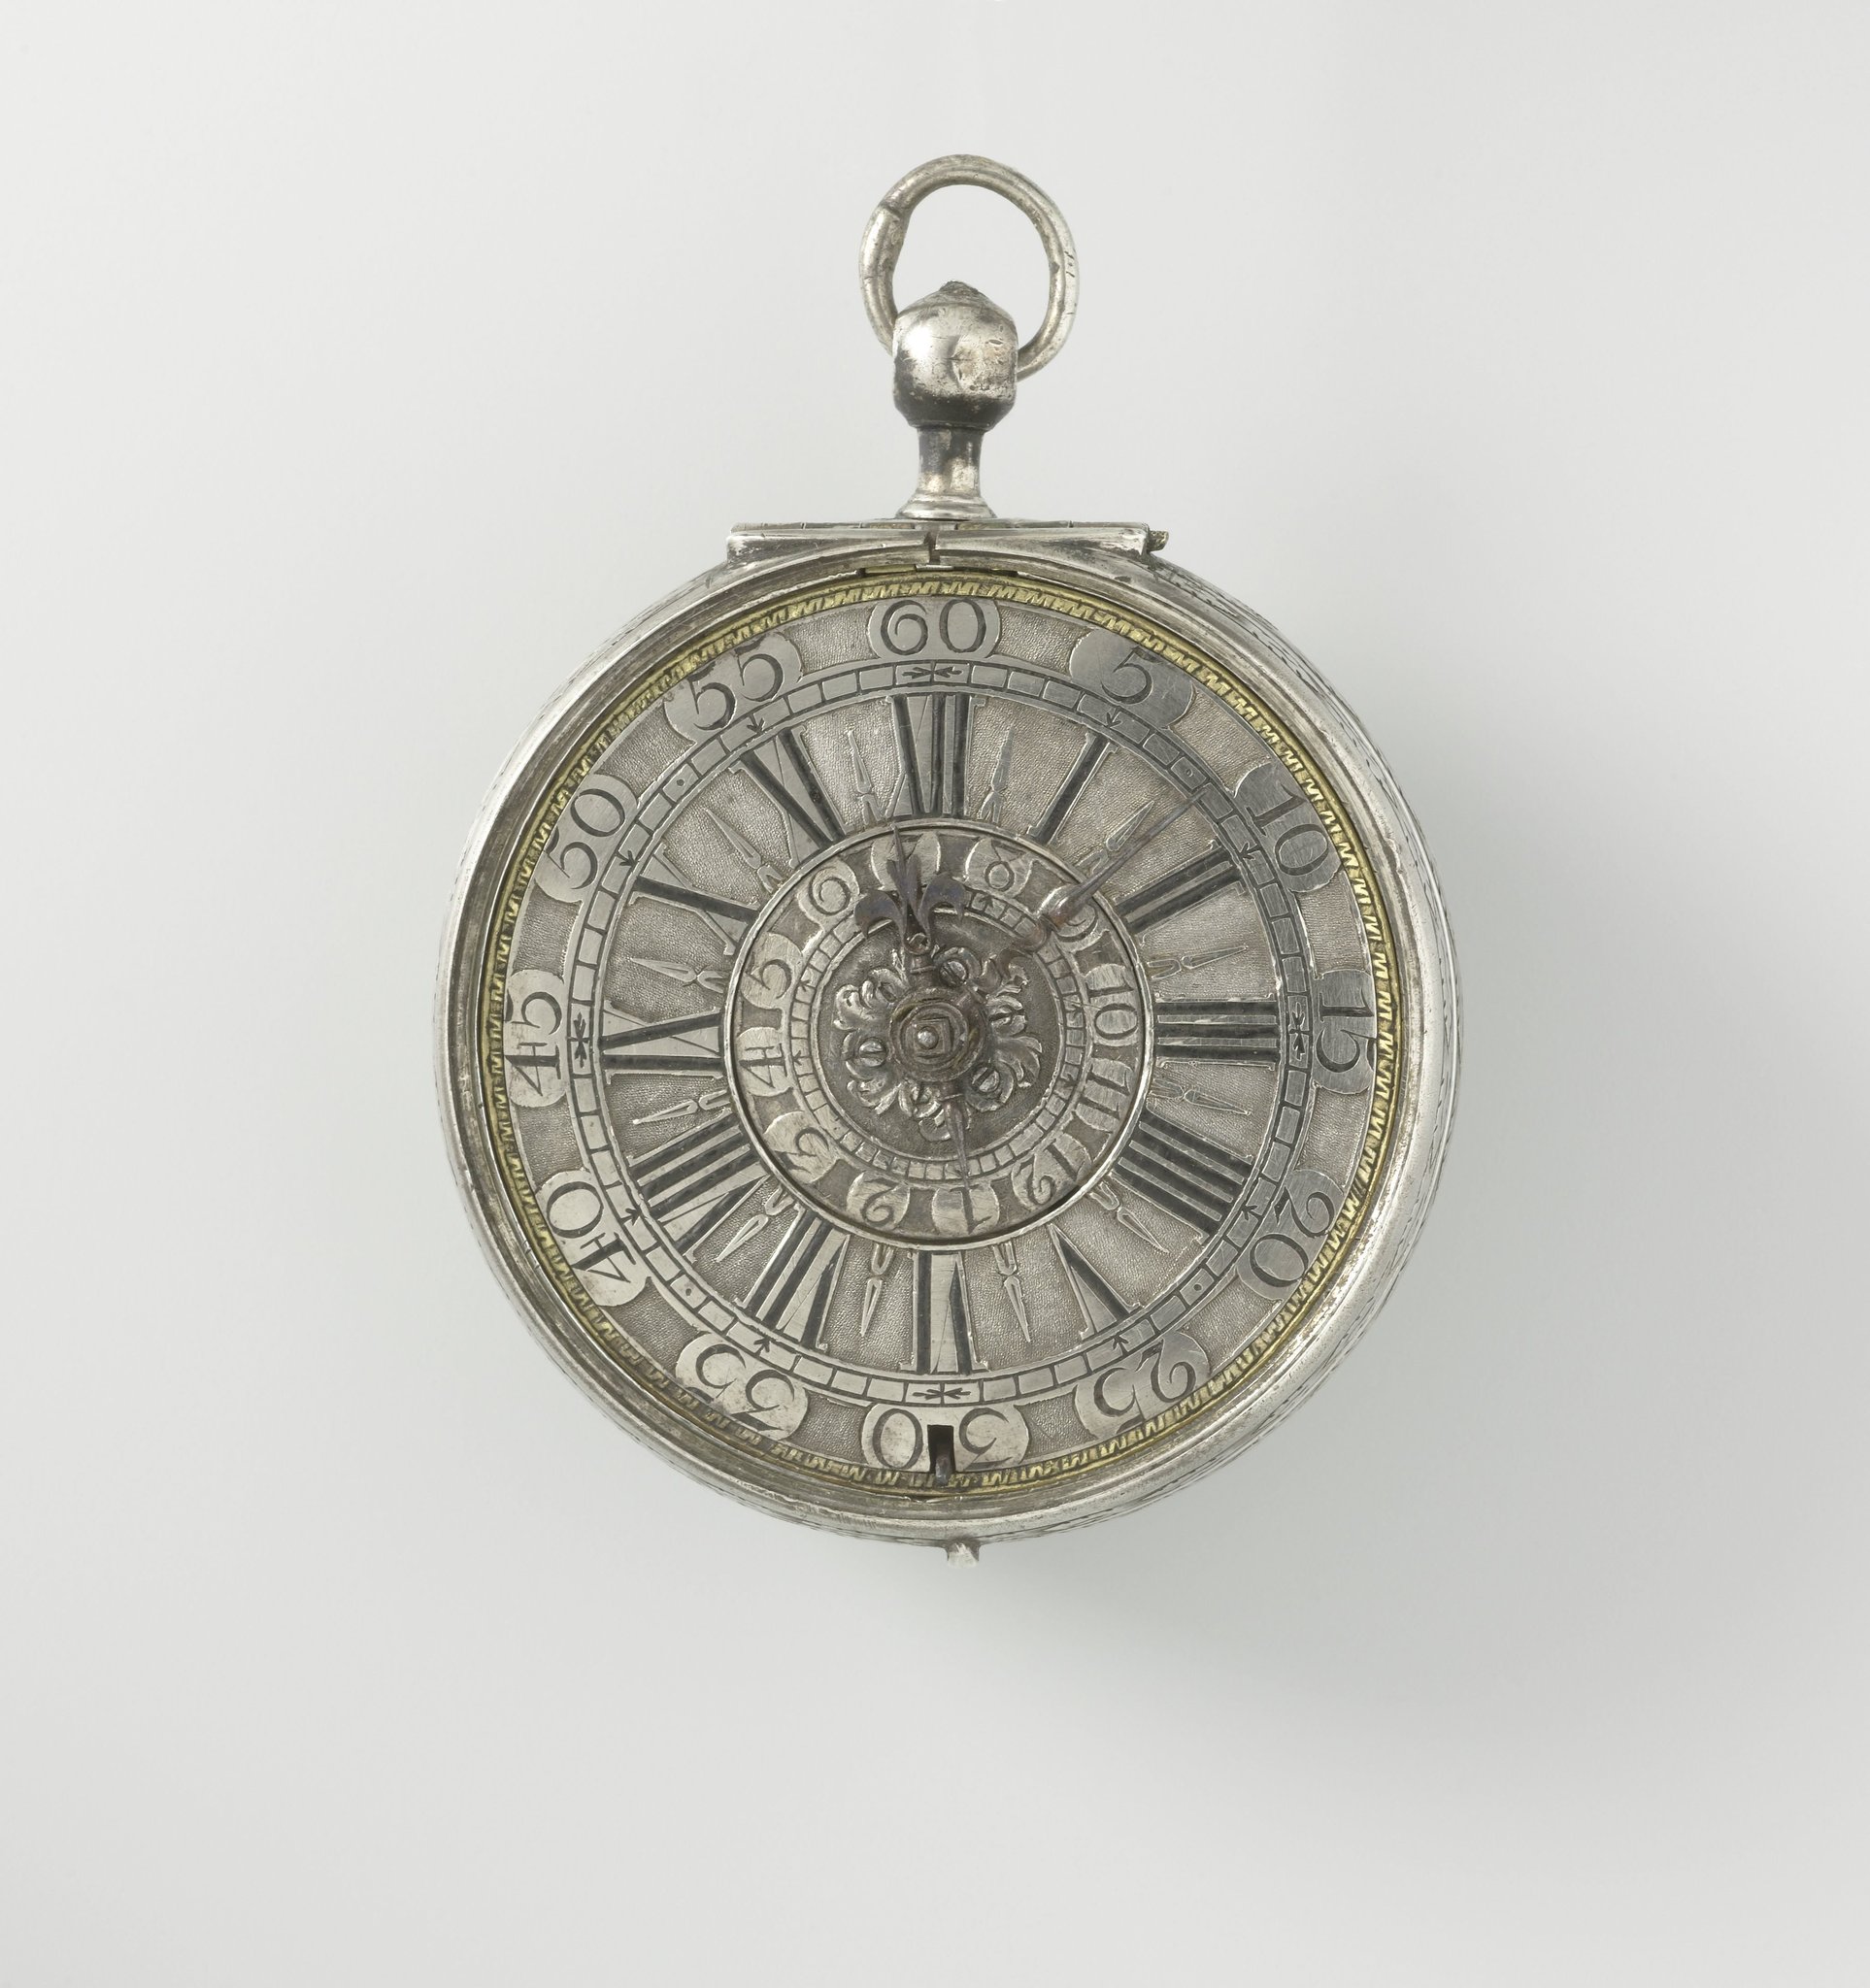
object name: jewellery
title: Pocket watch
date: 1680-1710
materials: silver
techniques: granulation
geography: netherlands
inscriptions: signature: ‘B. van der Cloese, Hagae’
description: Watches with an openwork or ajouré case often have an alarm, since the perforations in the case allow the sound of the bell to be heard. The movement is nevertheless well protected against dirt and dust because it has an inner and an outer case. The Dutch made this type of watchcase beginning around 1680: the exteriors were finely decorated with engraving. The openings in this case have a minutely executed pattern.